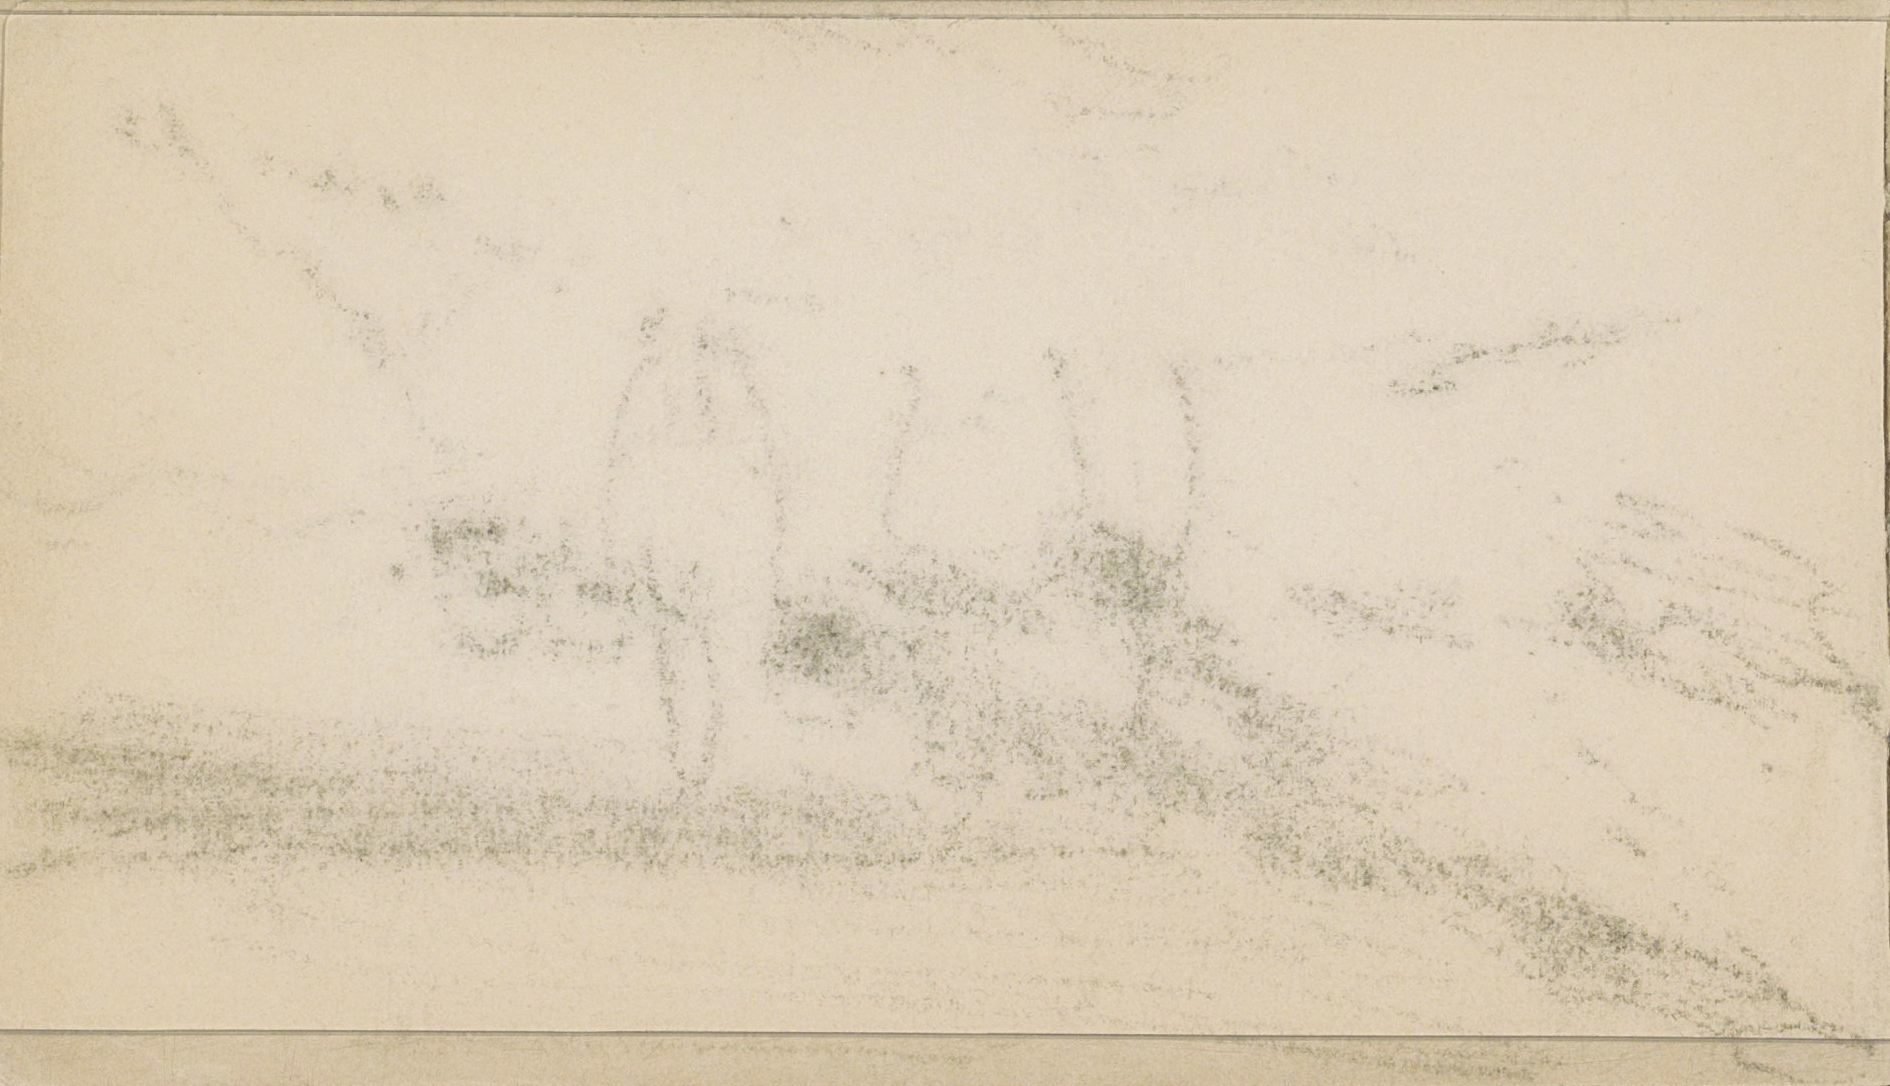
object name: sketchbook leaf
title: Abklatsch van de krijttekening op pagina 10 recto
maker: anton mauve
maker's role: draughtsman, painter, print maker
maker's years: 1838-1888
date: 1876-1879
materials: paper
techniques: printmaking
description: Blad 9 verso uit een schetsboek met 33 bladen.